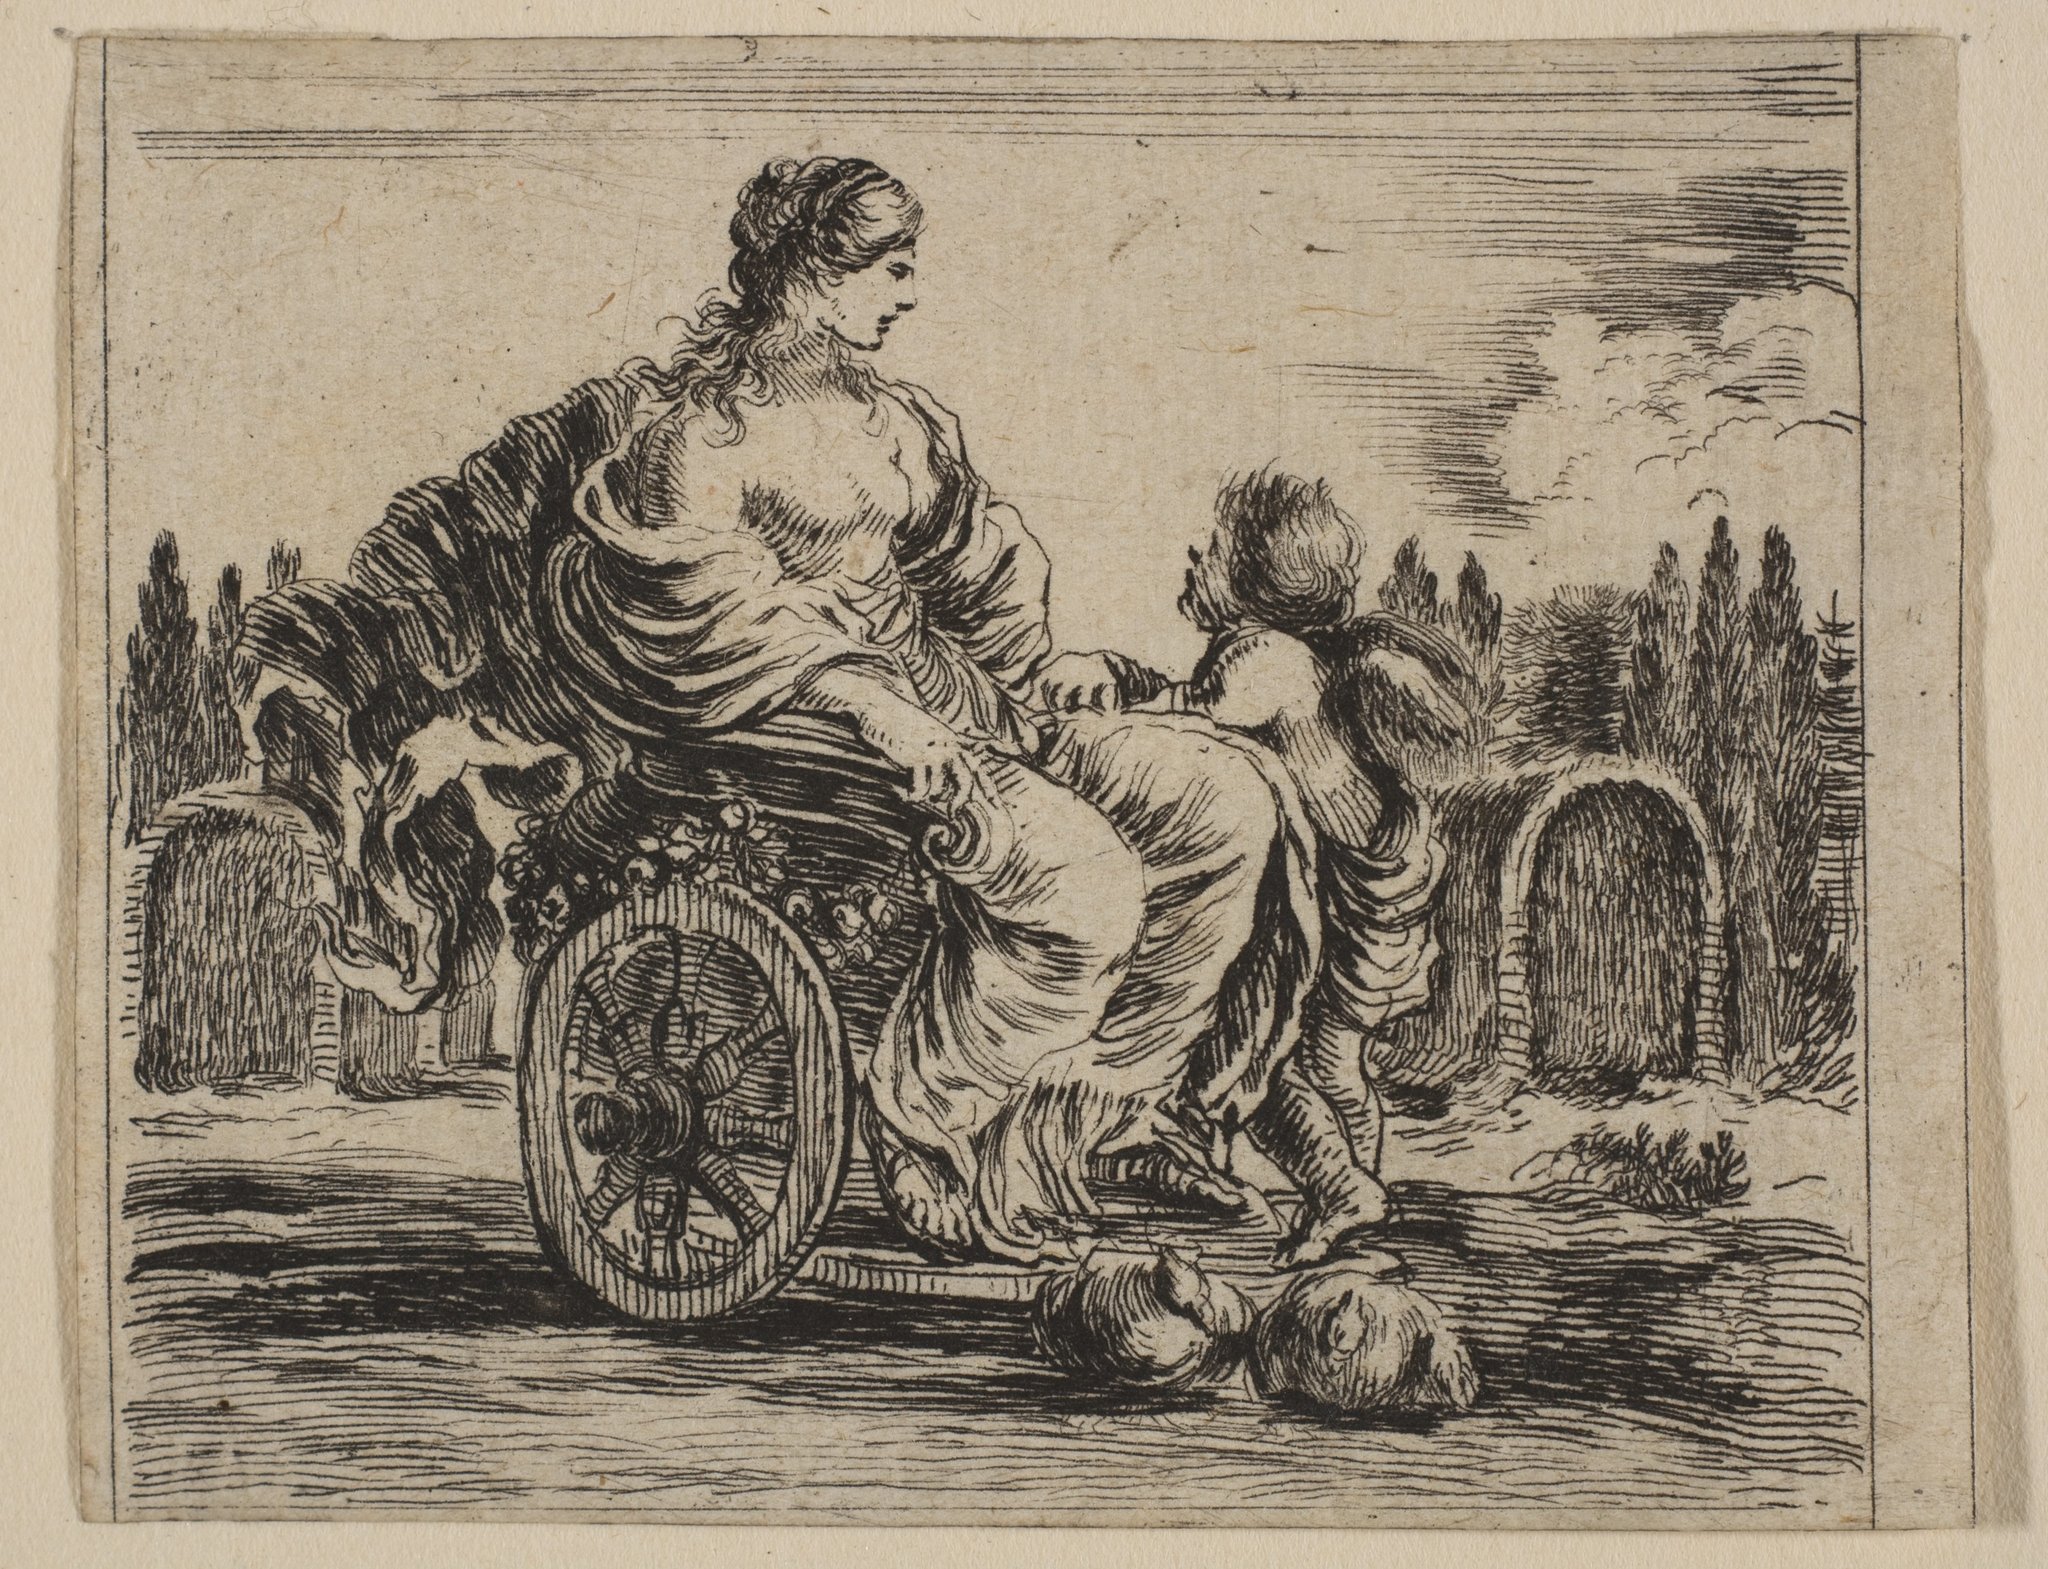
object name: print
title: Venus, from 'Game of Mythology' (Jeu de la Mythologie)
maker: stefano della bella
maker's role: artist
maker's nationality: italian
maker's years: 1610-1664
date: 1644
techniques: etching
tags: cupid,venus